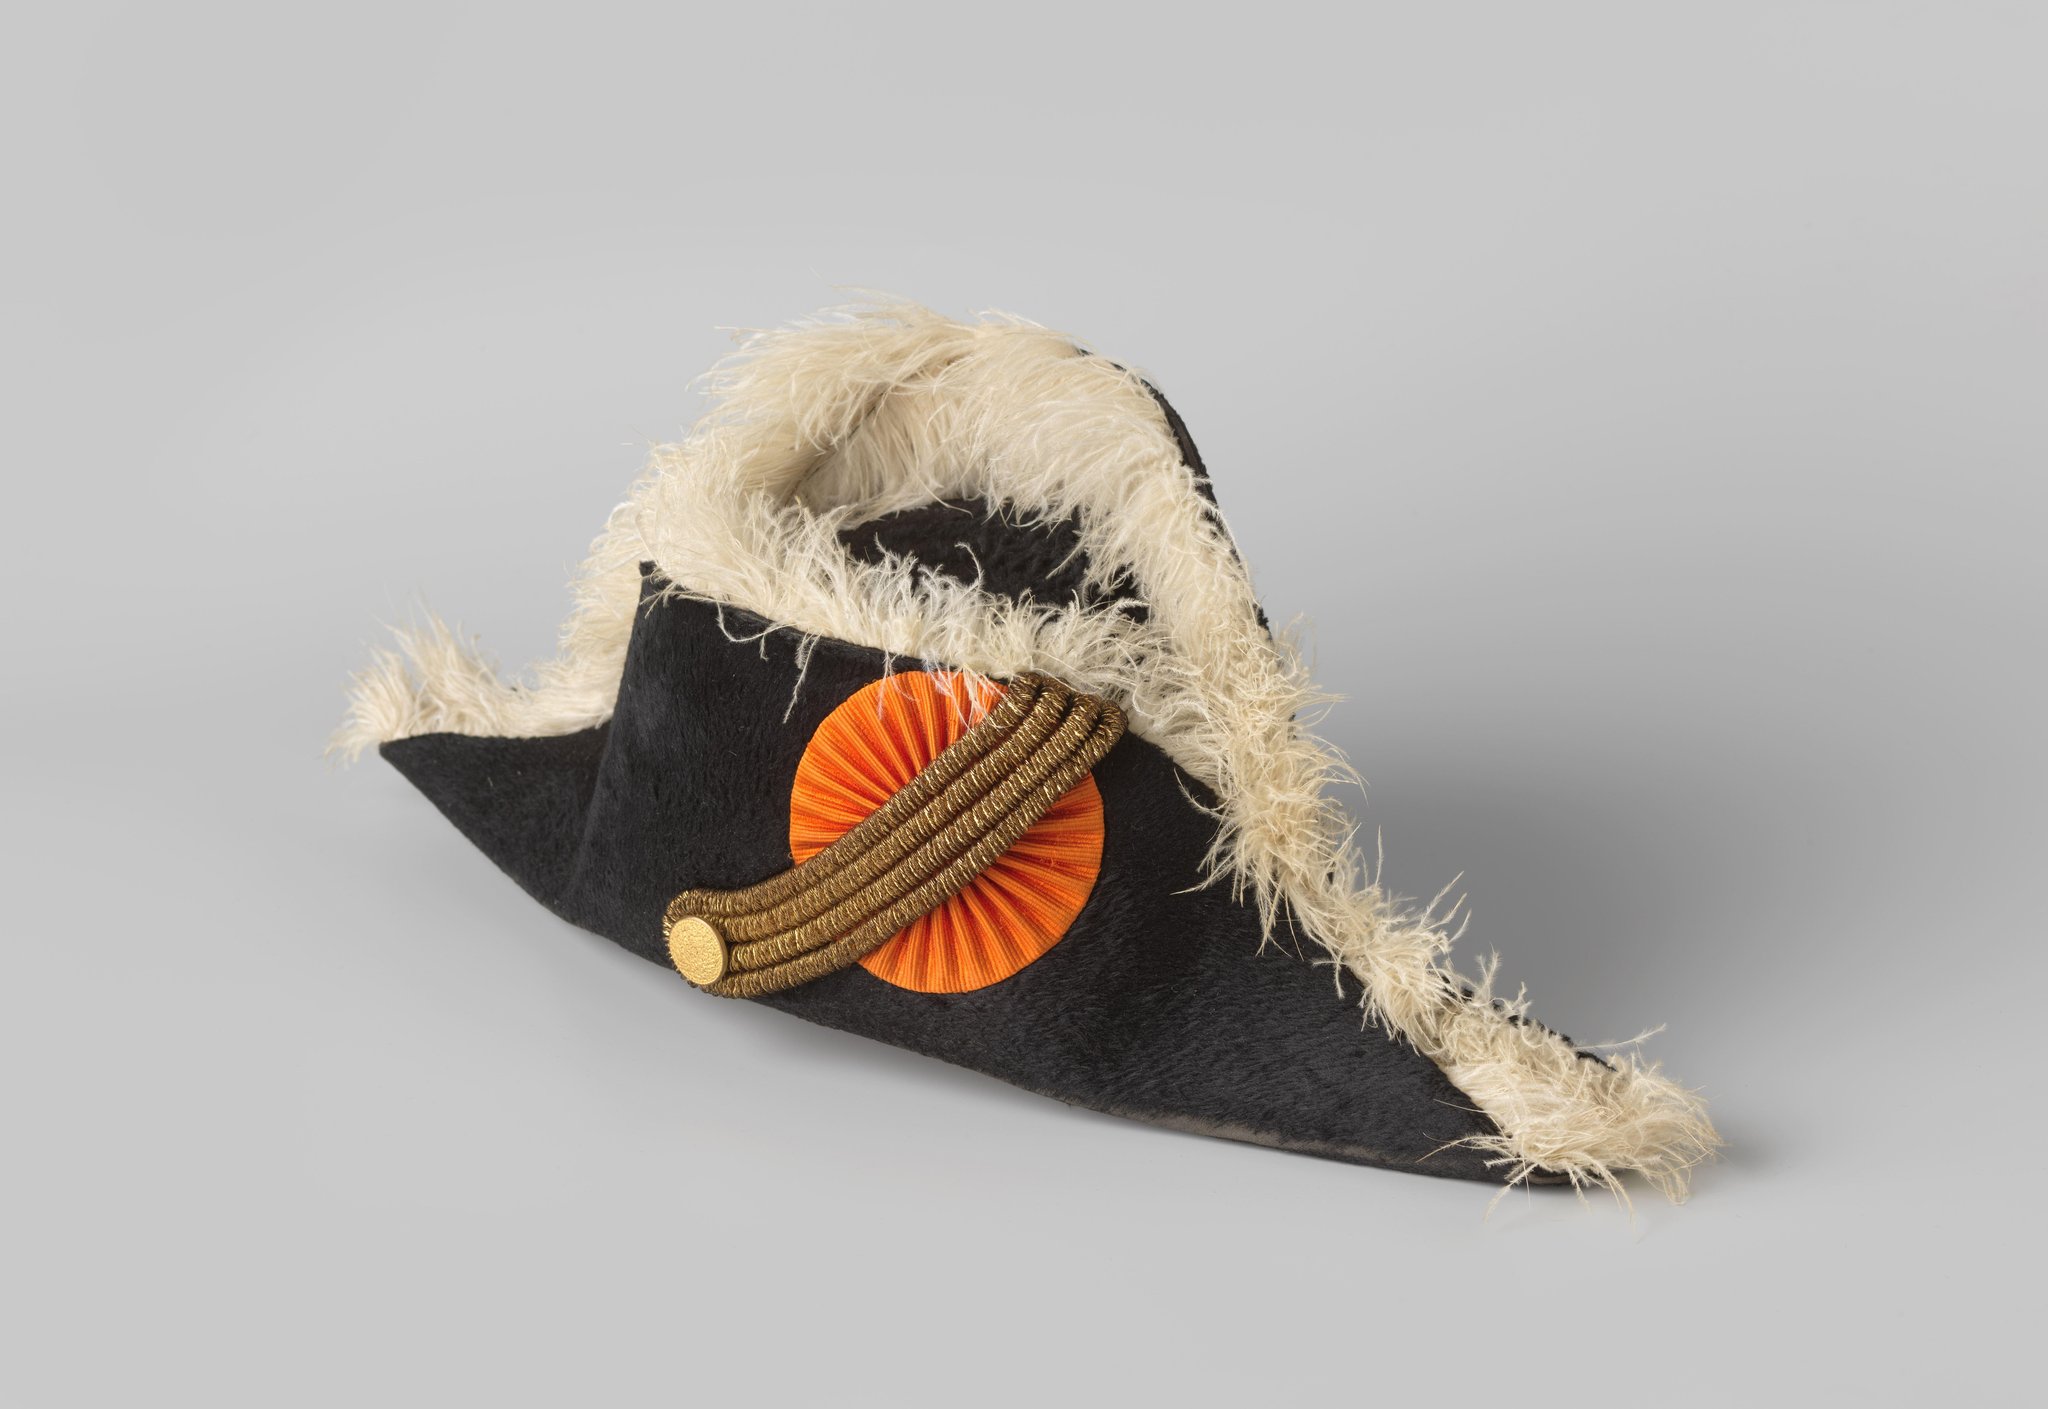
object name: bicorne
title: Steek van gala-kostuum van lid Erewacht tijdens de inhuldiging van koningin Juliana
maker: johannes sebastianus meuwsen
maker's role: hoedenmaker, koopman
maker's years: 1862-1915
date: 1909-1948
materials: textile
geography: netherlands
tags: erich hartmann, the hague, juliana of the netherlands, amsterdam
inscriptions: label: ‘J.S. MEUWSEN / HOFLEVERANCIER. / AMSTERDAM. / DEN HAAG. / ROTTERDAM.’, inscription: ‘E / H’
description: Steek van zwarte pluizige stof met witte struisveren met aan één zijde een oranje rozet. Gedragen door Ernst Hartmann, lid Erewacht, tijdens de inhuldiging van koningin Juliana op 6 september 1948.